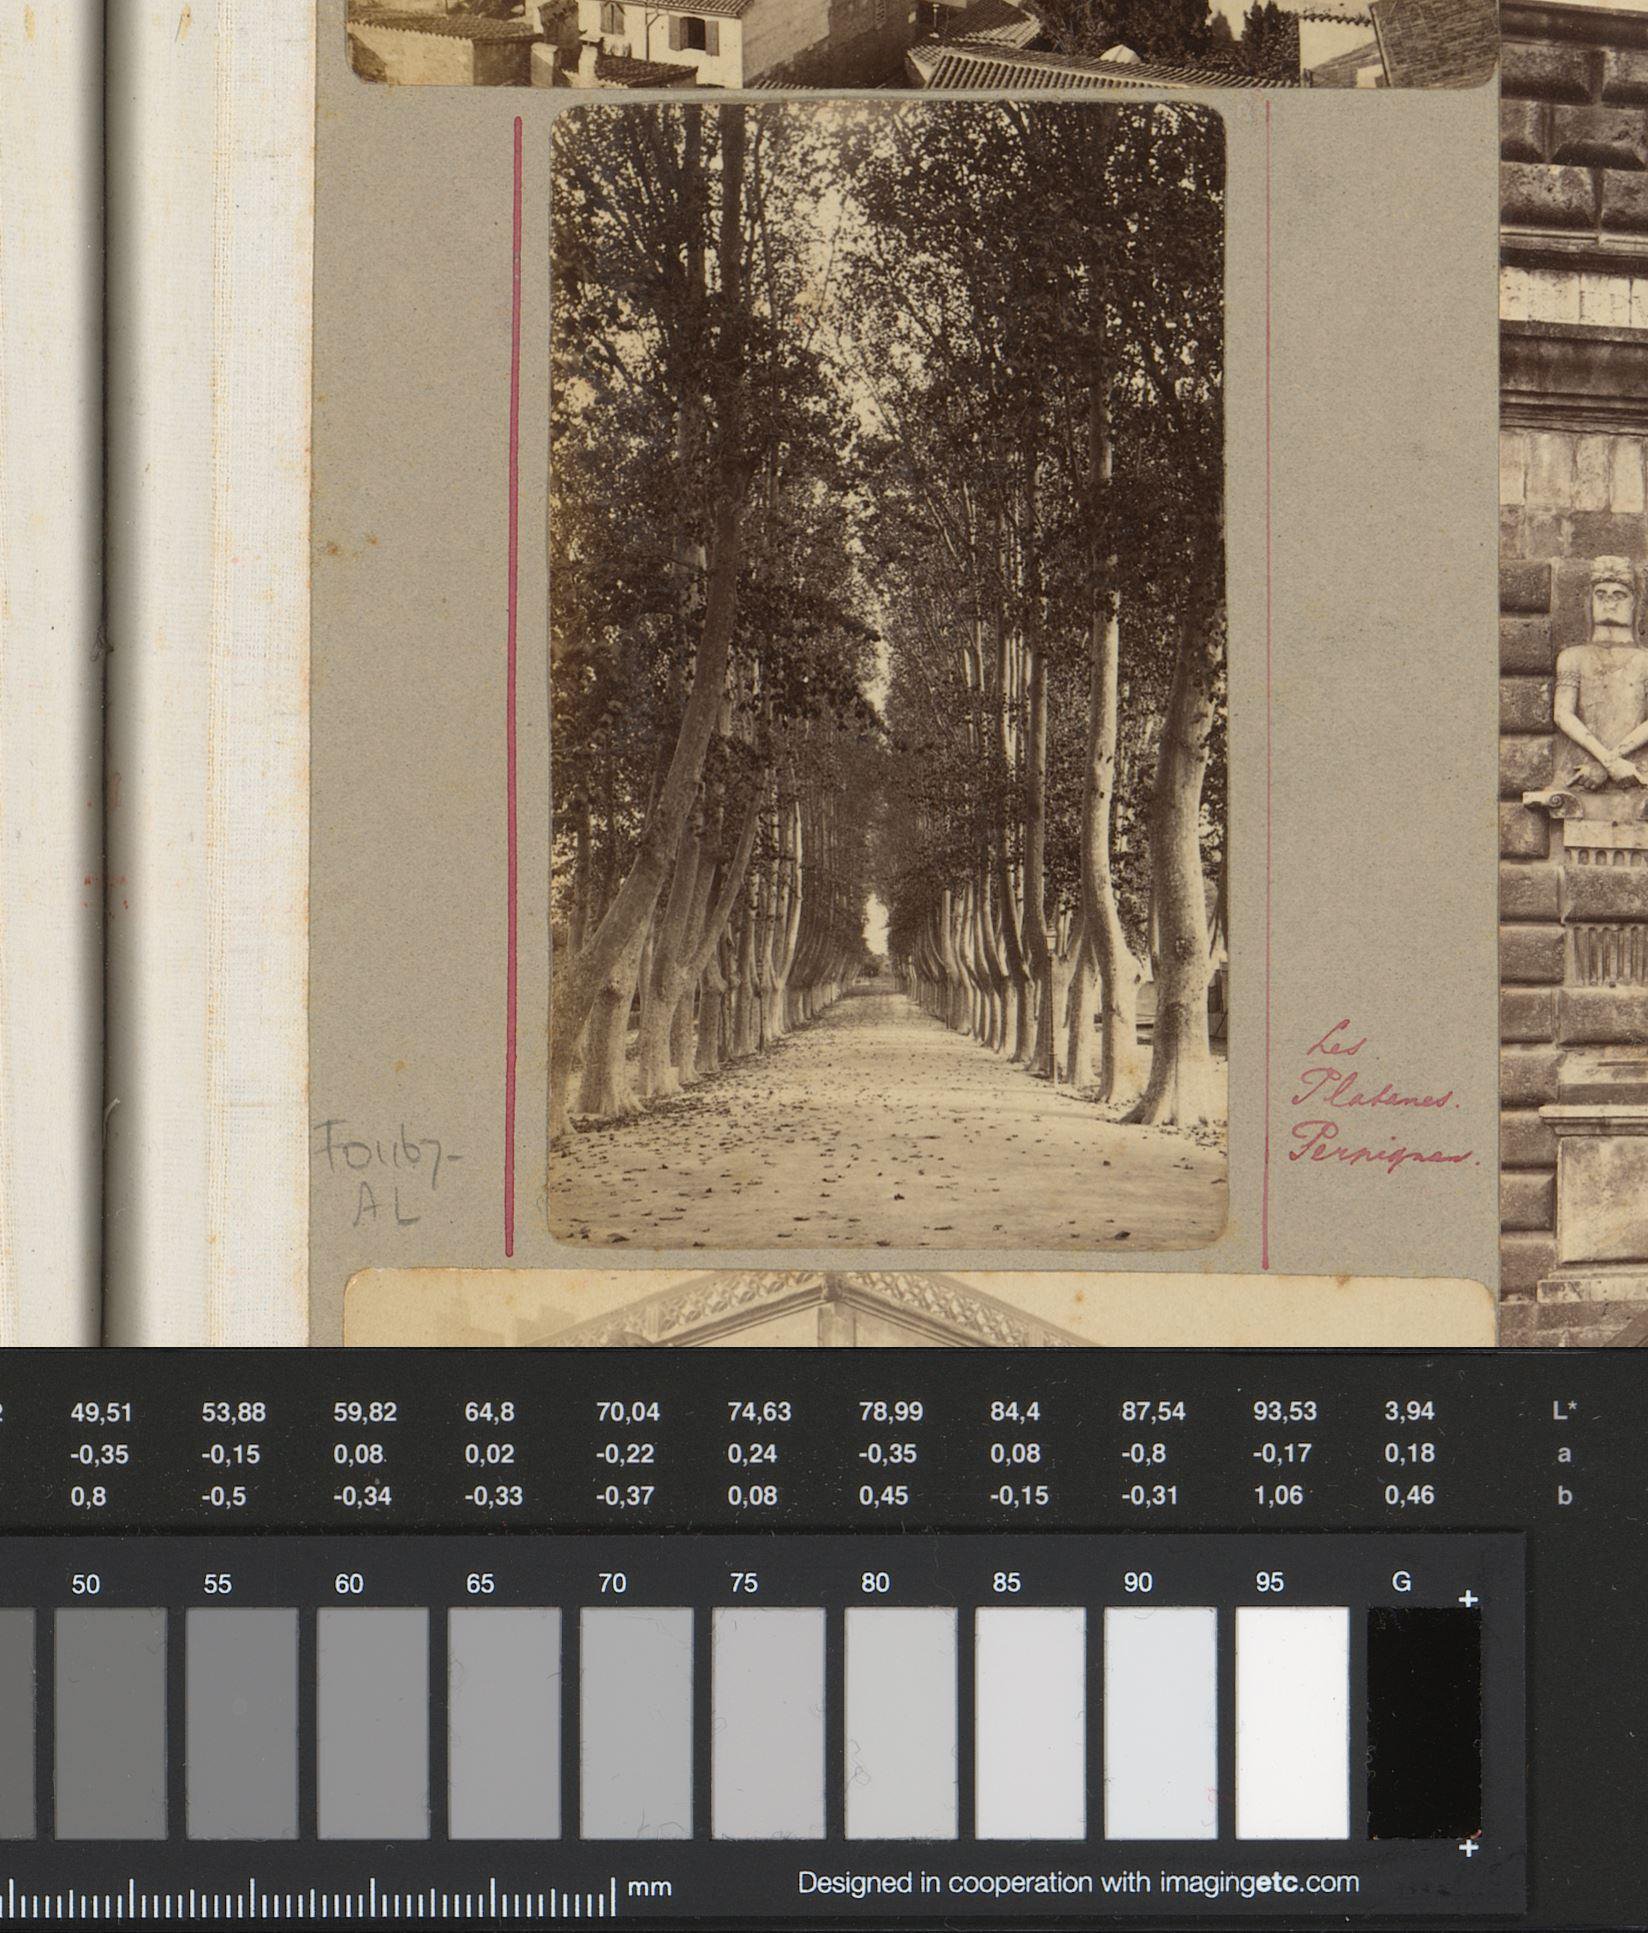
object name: photograph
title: Laan met platanen te Perpignan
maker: Anonymous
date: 1880-1910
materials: photographic support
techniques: albumen print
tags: trees: plane-tree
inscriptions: annotation: ‘Les platanes Perpignan’